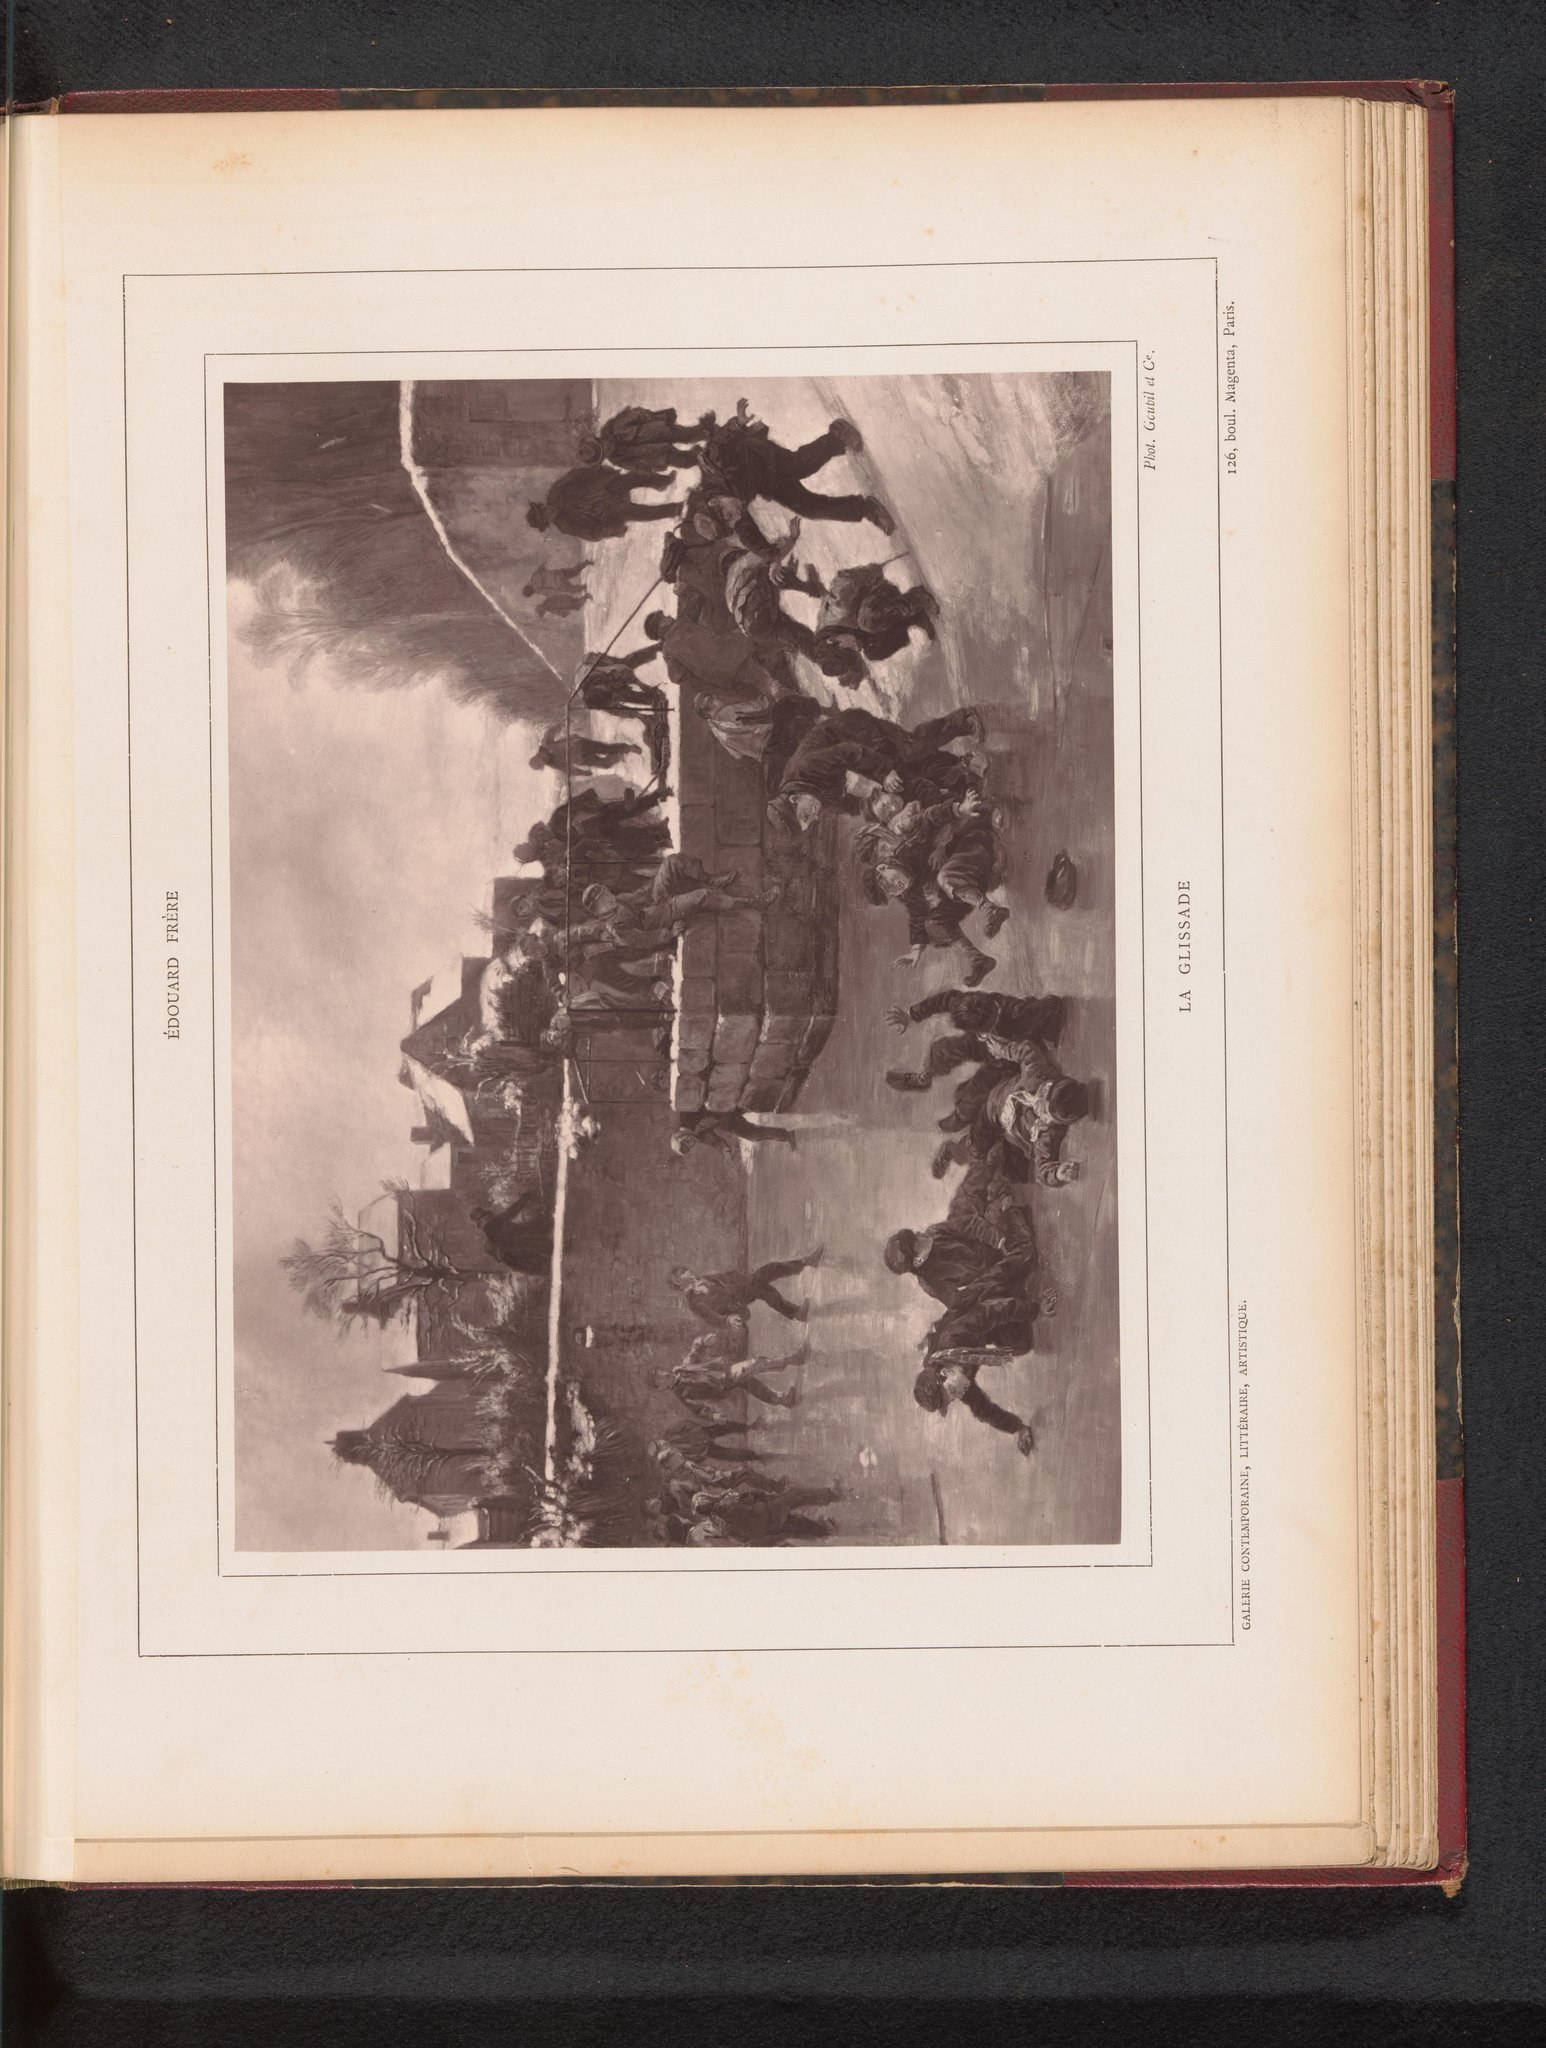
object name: page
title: Reproductie van La glissade door Pierre Edouard Frère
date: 1871-1876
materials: paper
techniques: woodburytype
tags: boy (child between toddler and youth), child and nature (games and plays), painting, drawing and the graphic arts